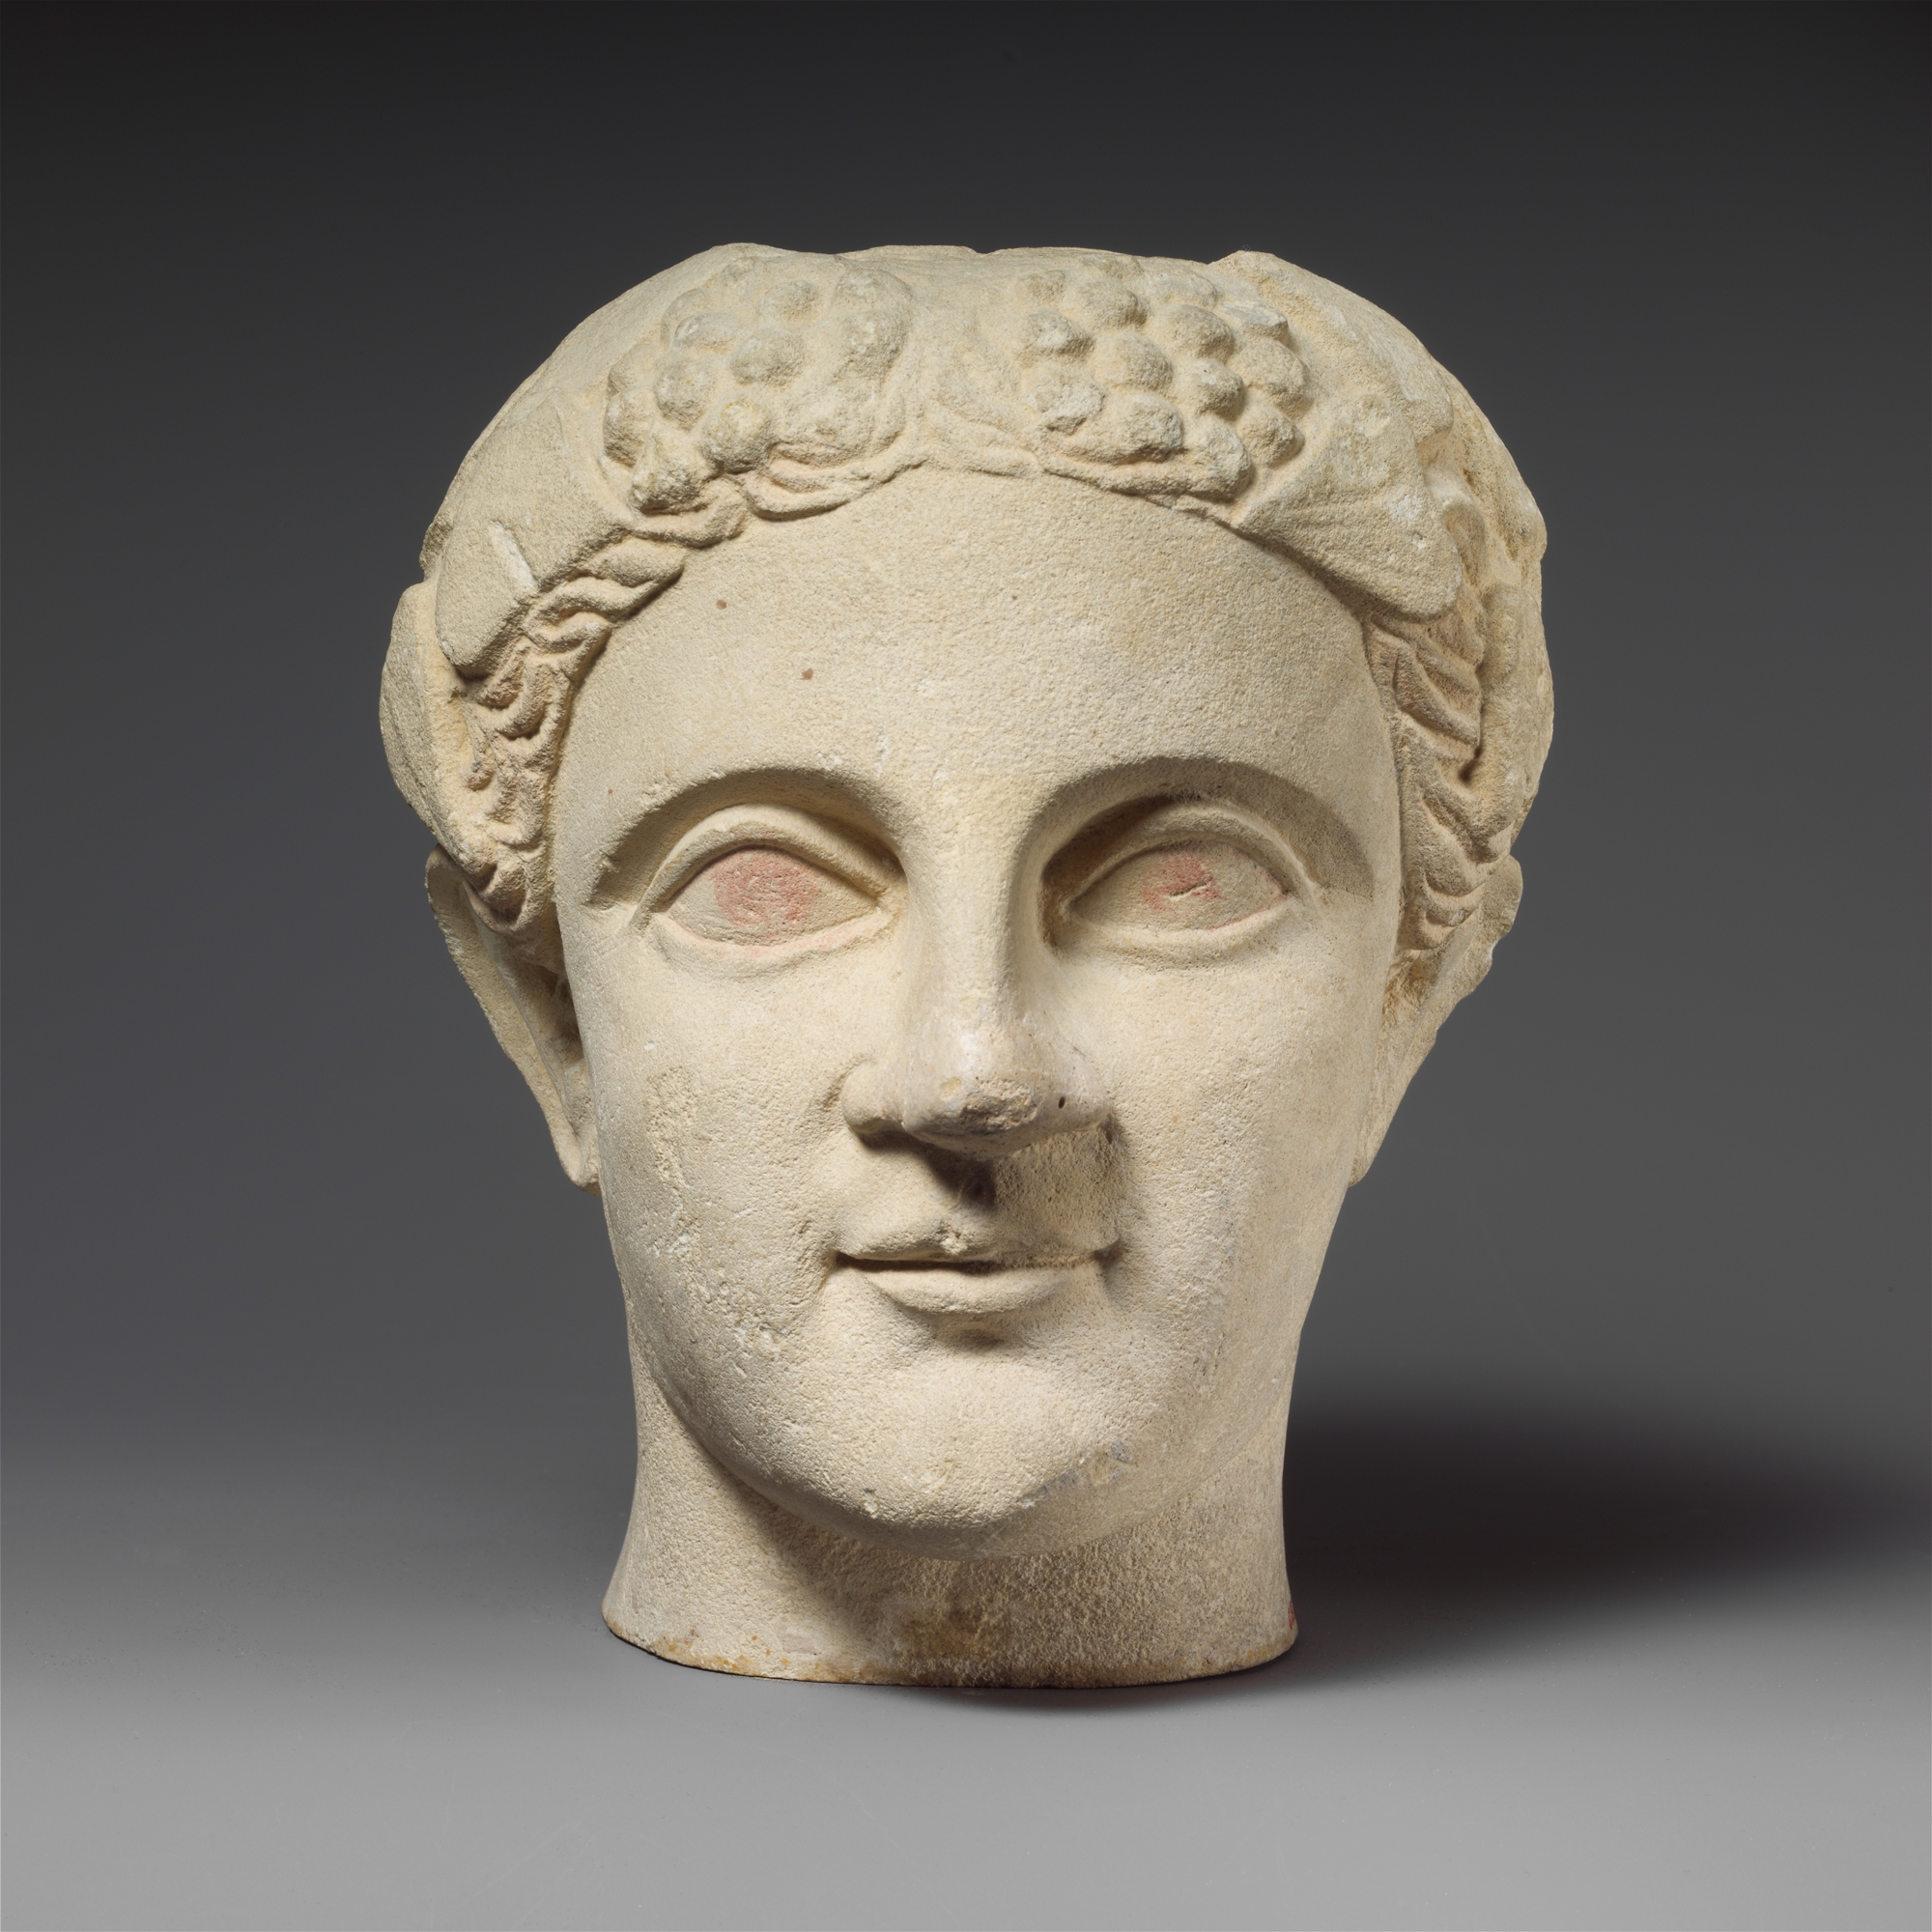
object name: head of a male votary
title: Limestone head of a wreathed youth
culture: cypriot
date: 400-301 BCE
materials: limestone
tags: heads,boys,wreaths